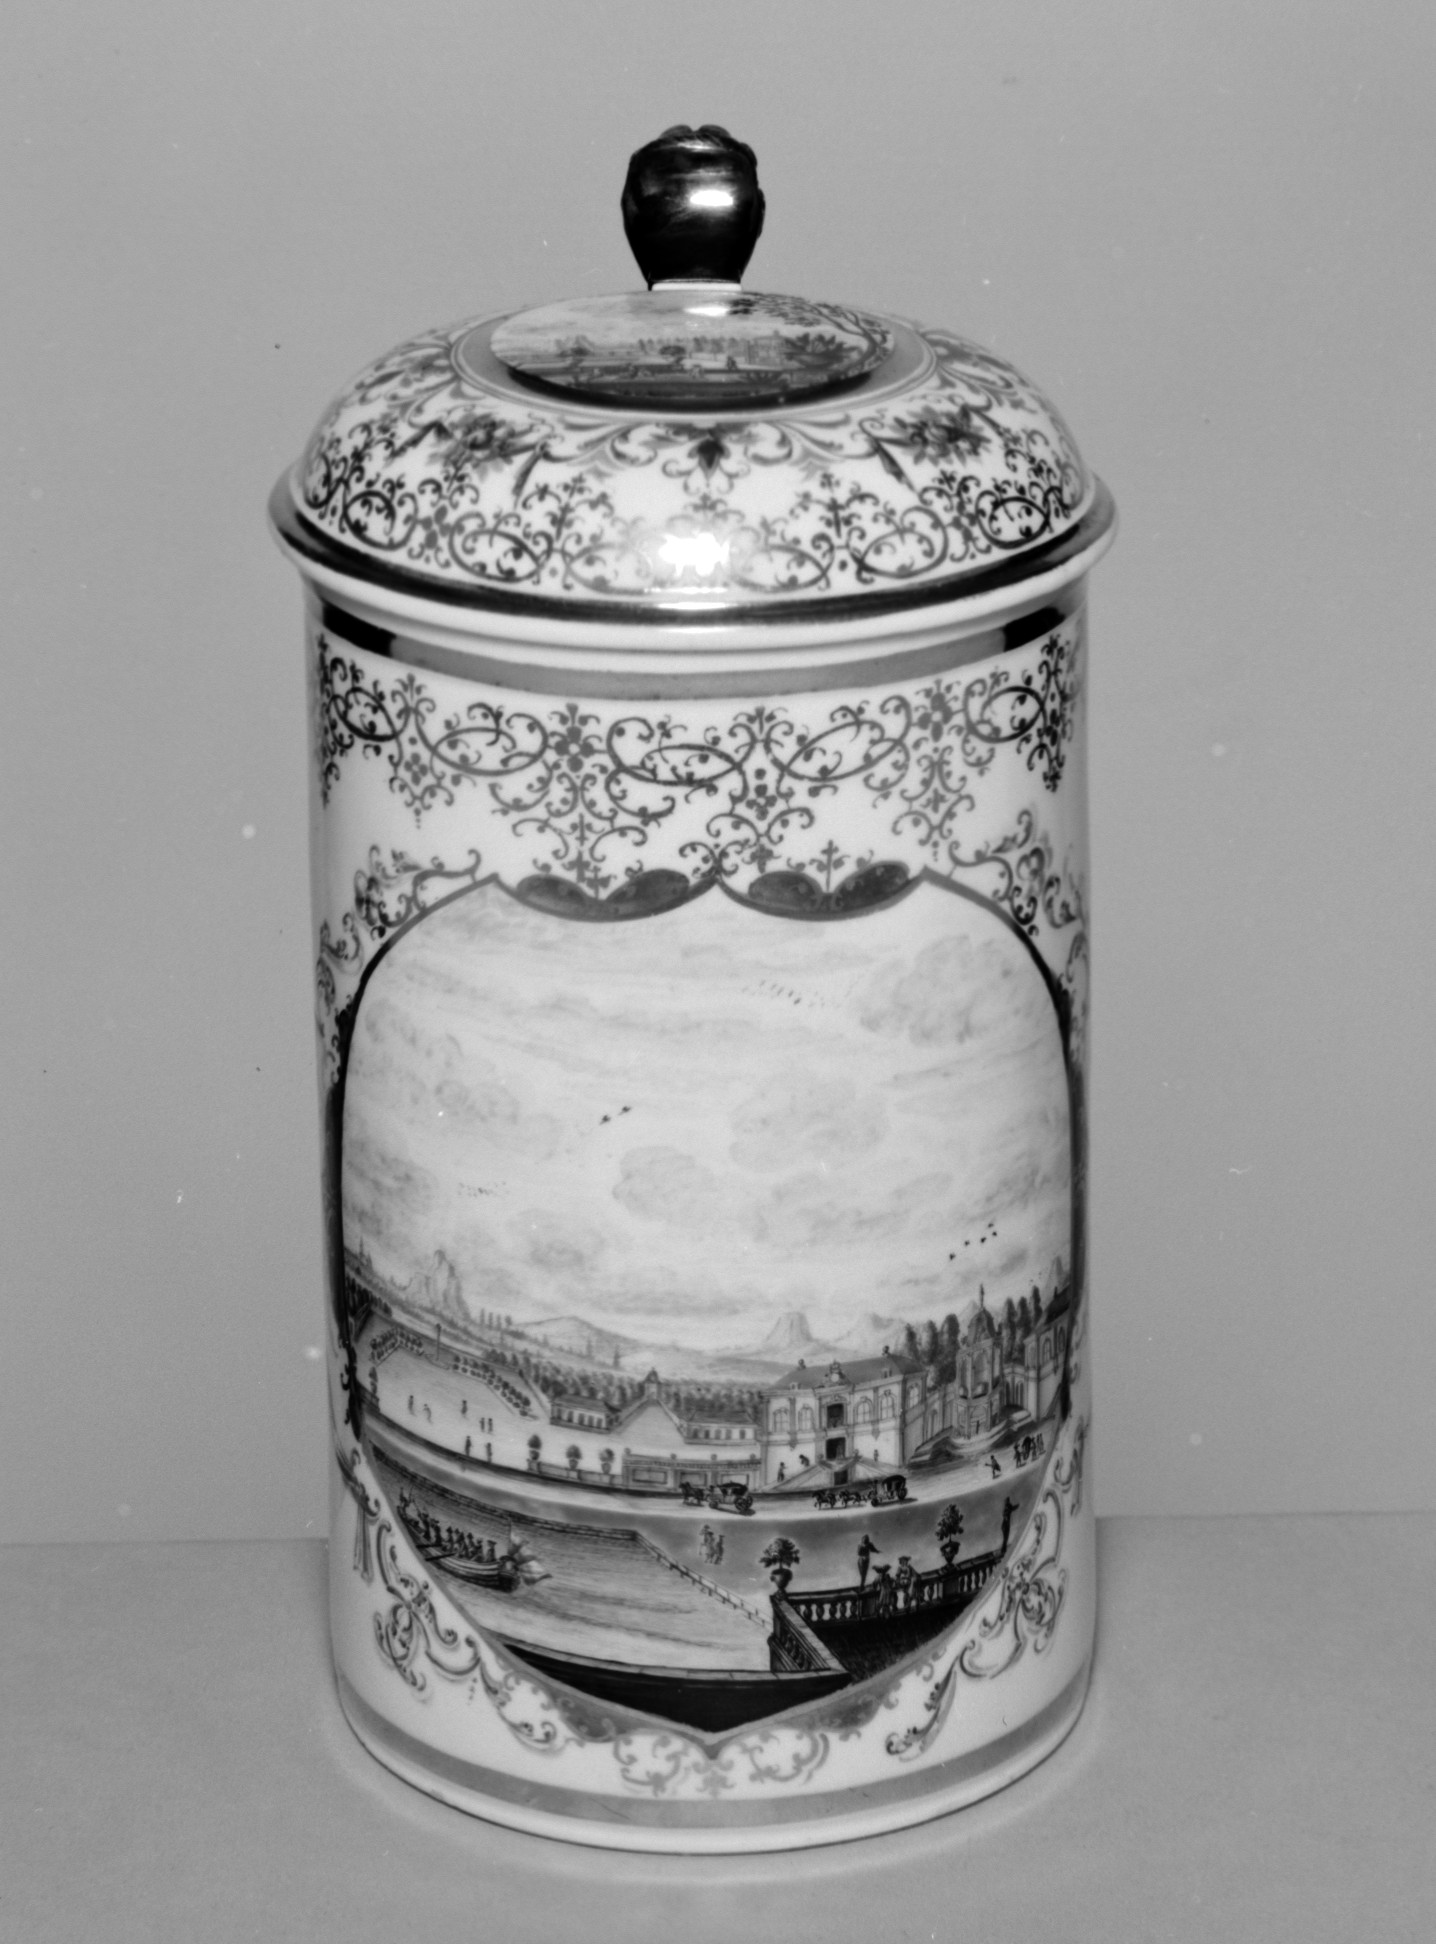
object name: tankard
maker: meissen manufactory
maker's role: manufactory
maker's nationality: german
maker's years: 1710-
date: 1735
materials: hard paste porcelain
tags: buildings,boats